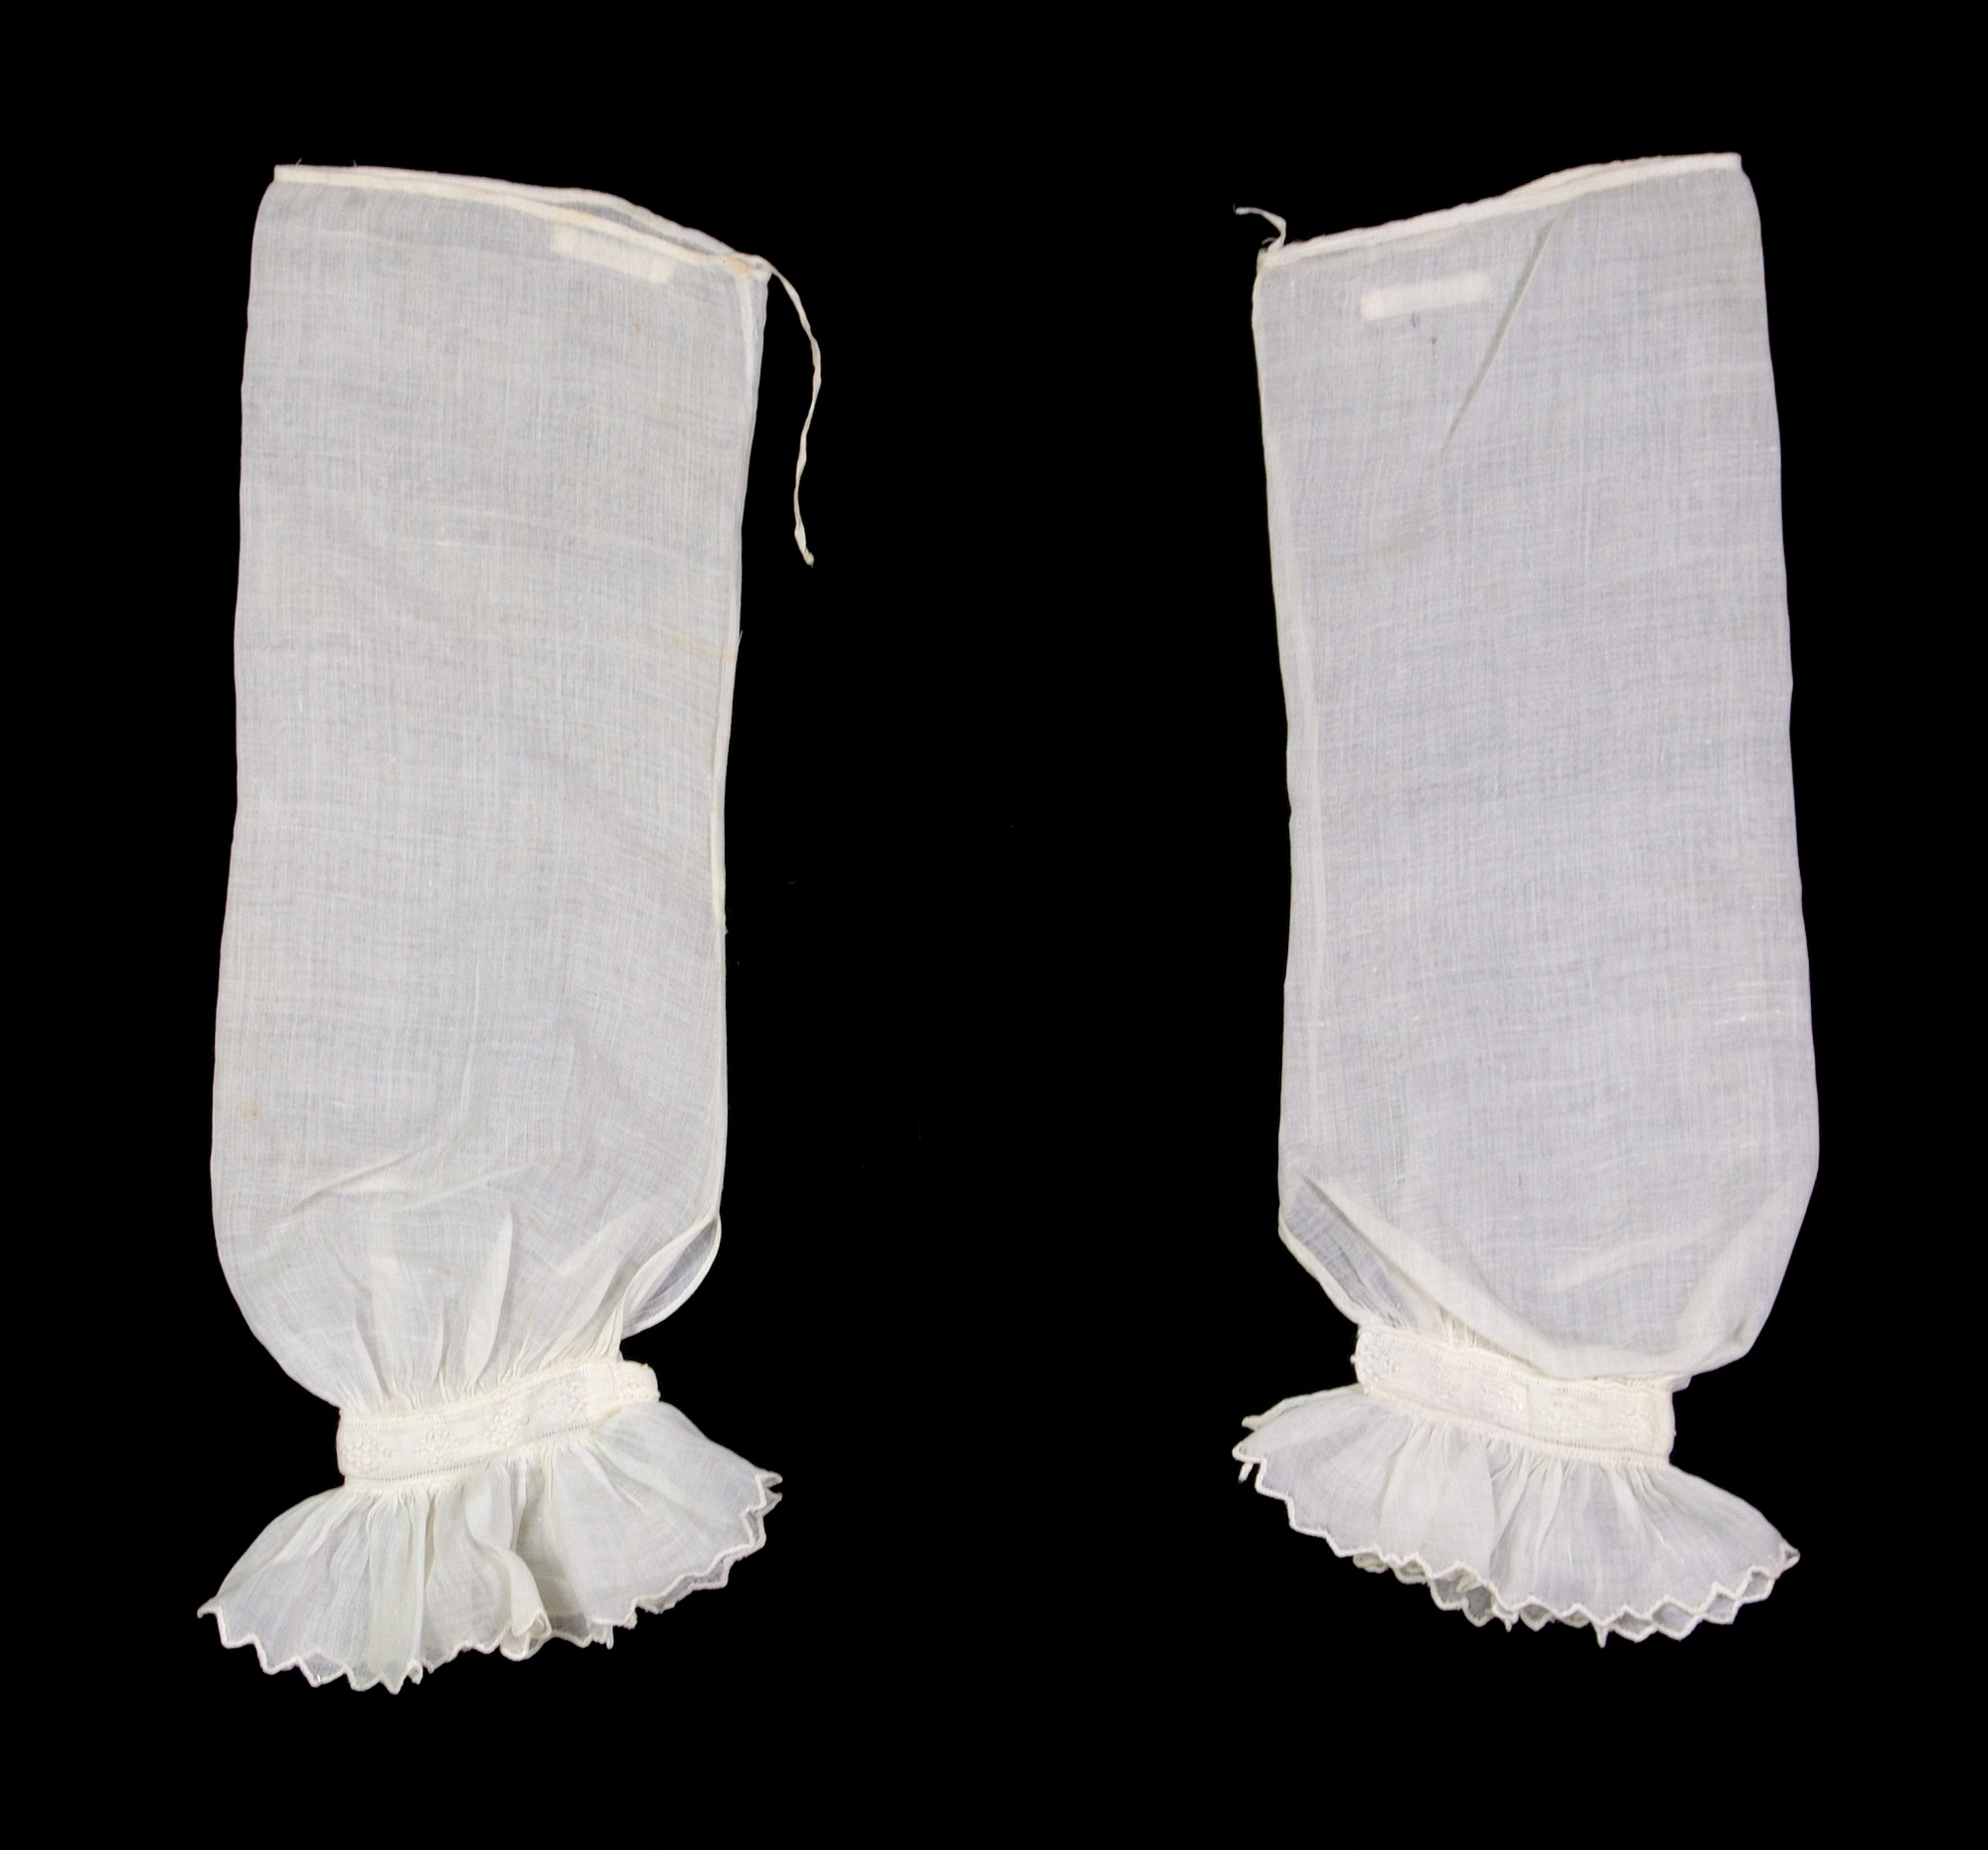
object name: undersleeves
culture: american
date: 1826-1850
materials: cotton